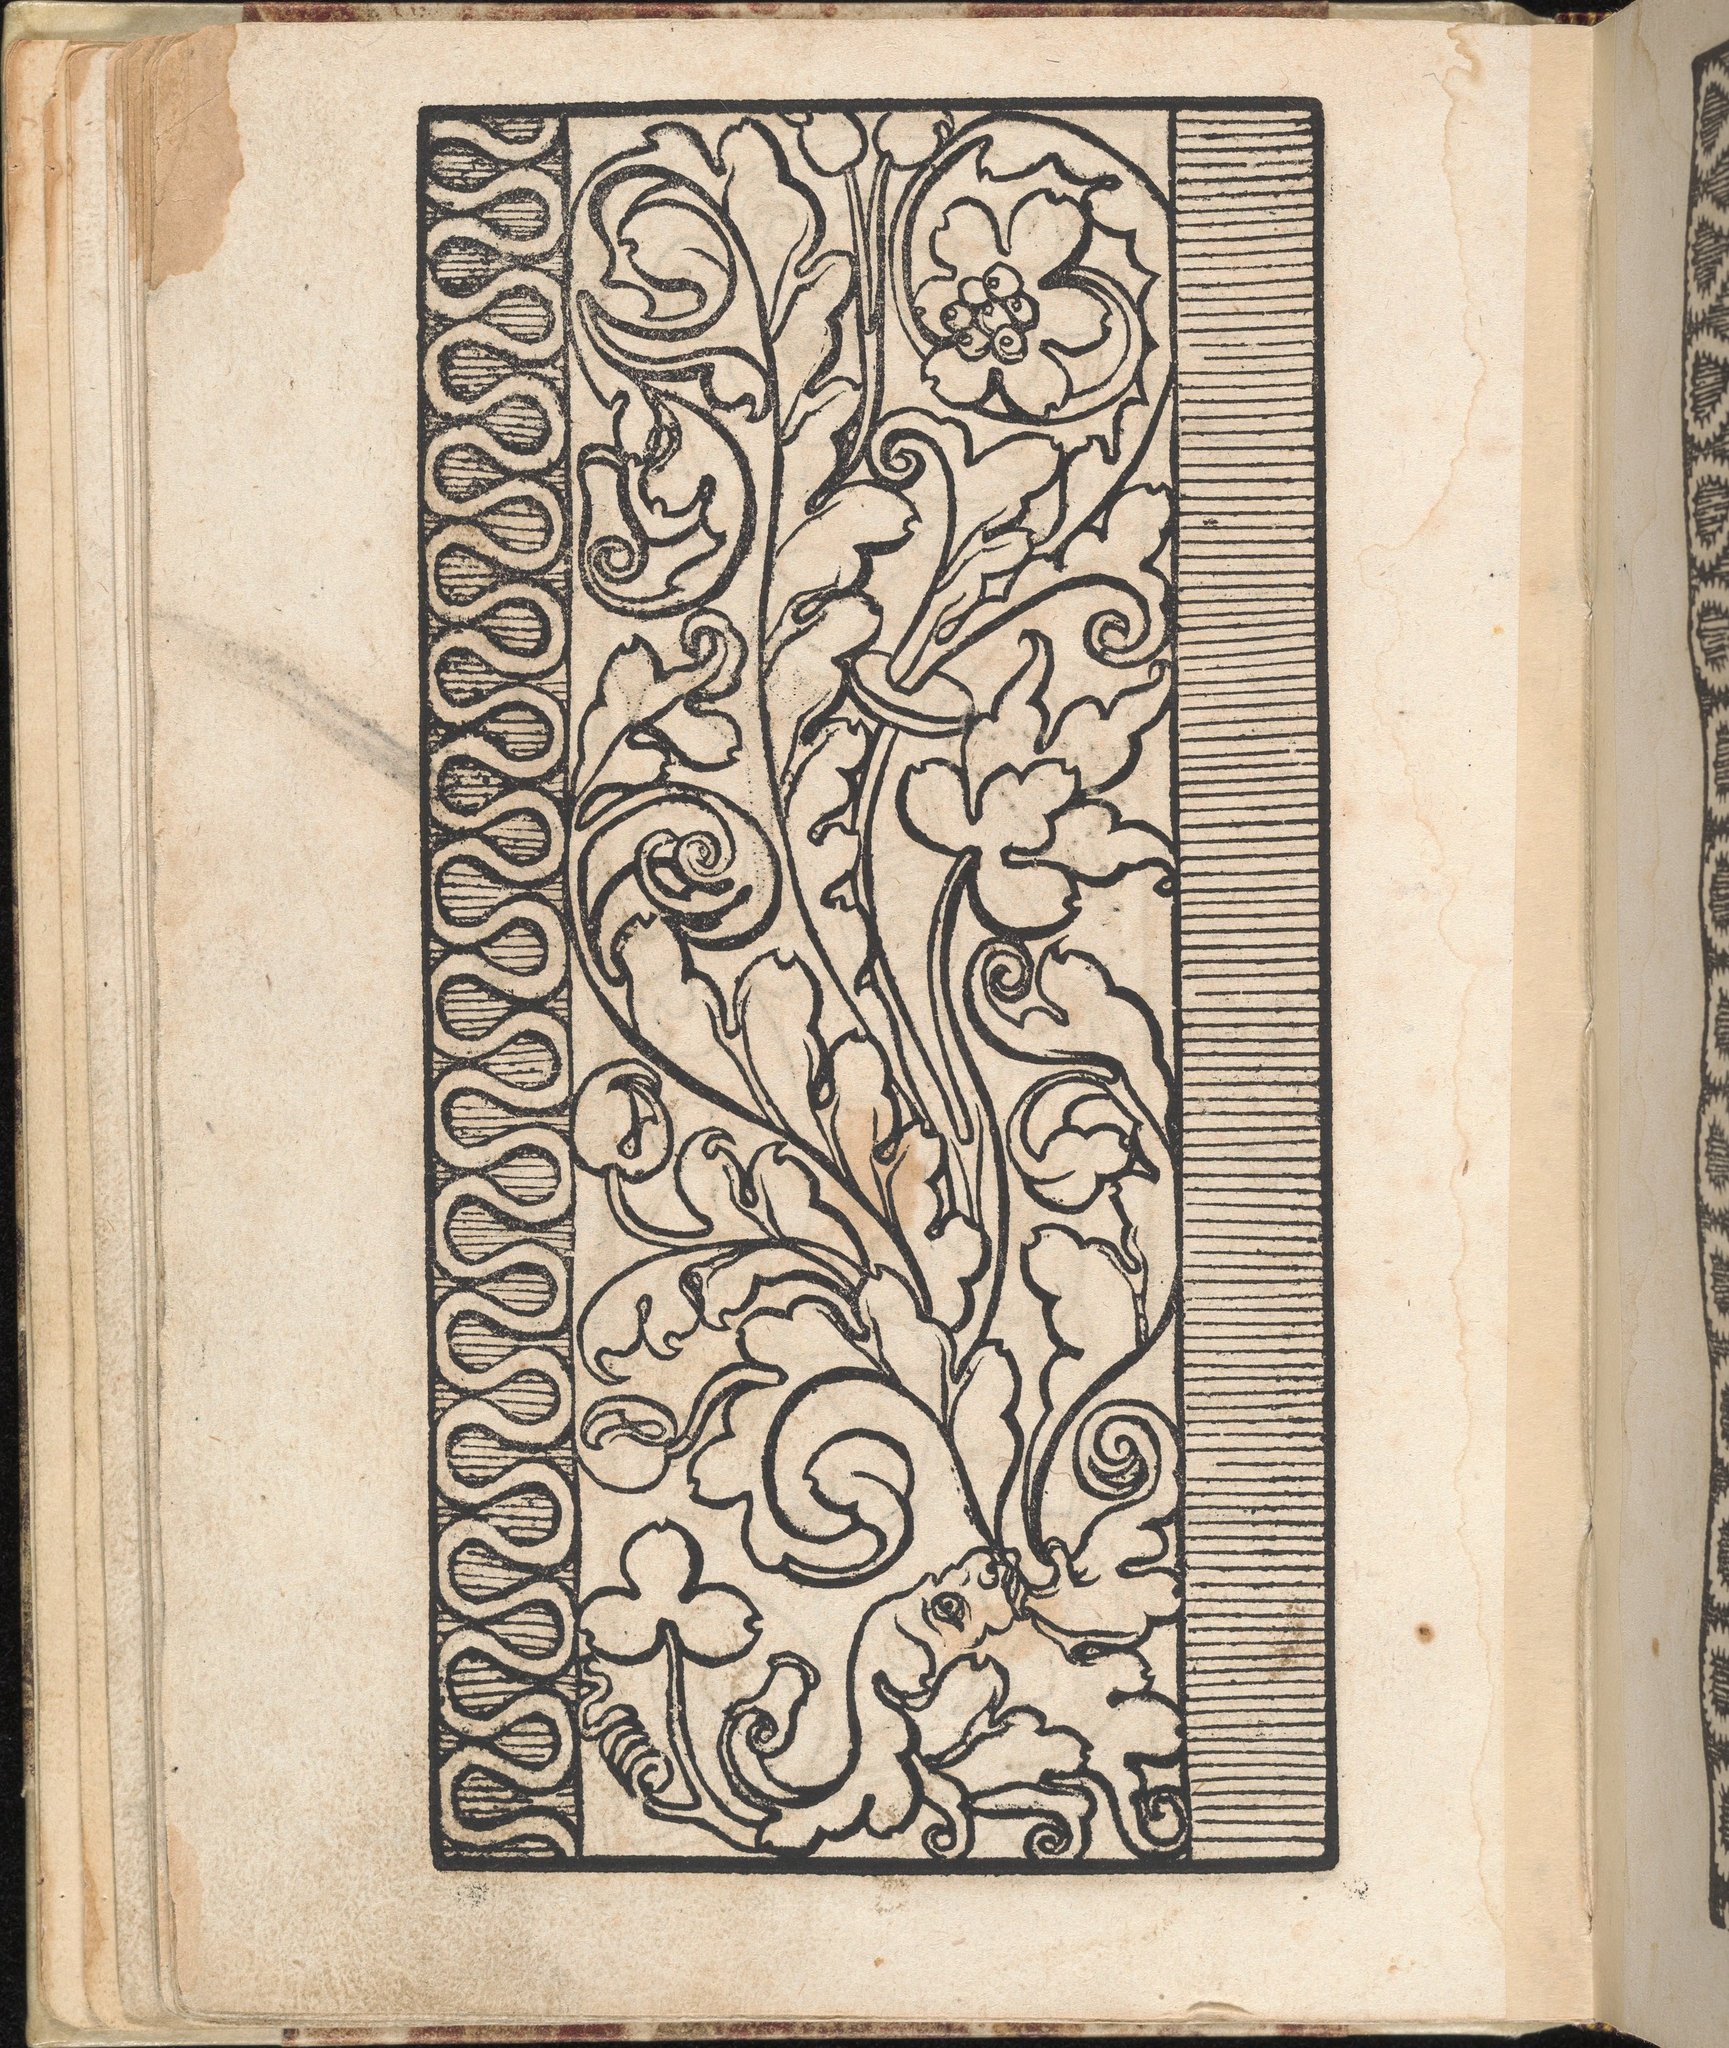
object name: book print ornament architecture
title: Ein new getruckt model Büchli...Page 22, verso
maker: johann schönsperger the younger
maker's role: publisher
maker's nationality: german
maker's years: 1490-1550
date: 1529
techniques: woodcut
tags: ornament